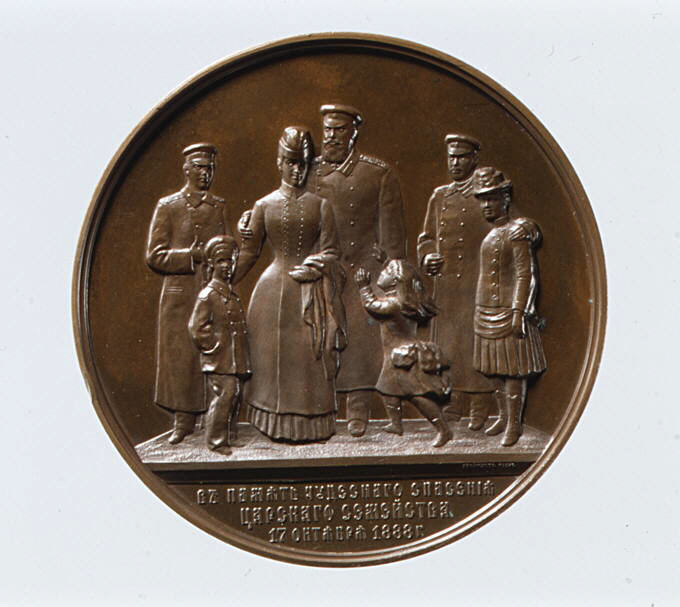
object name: medal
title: The Miraculous Rescue of Alexander III and the Imperial Family, 1888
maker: avenir crigorjewitsch grilliches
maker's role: artist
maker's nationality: russian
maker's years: 1849-1905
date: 1888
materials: bronze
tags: boys,girls,men,women,family